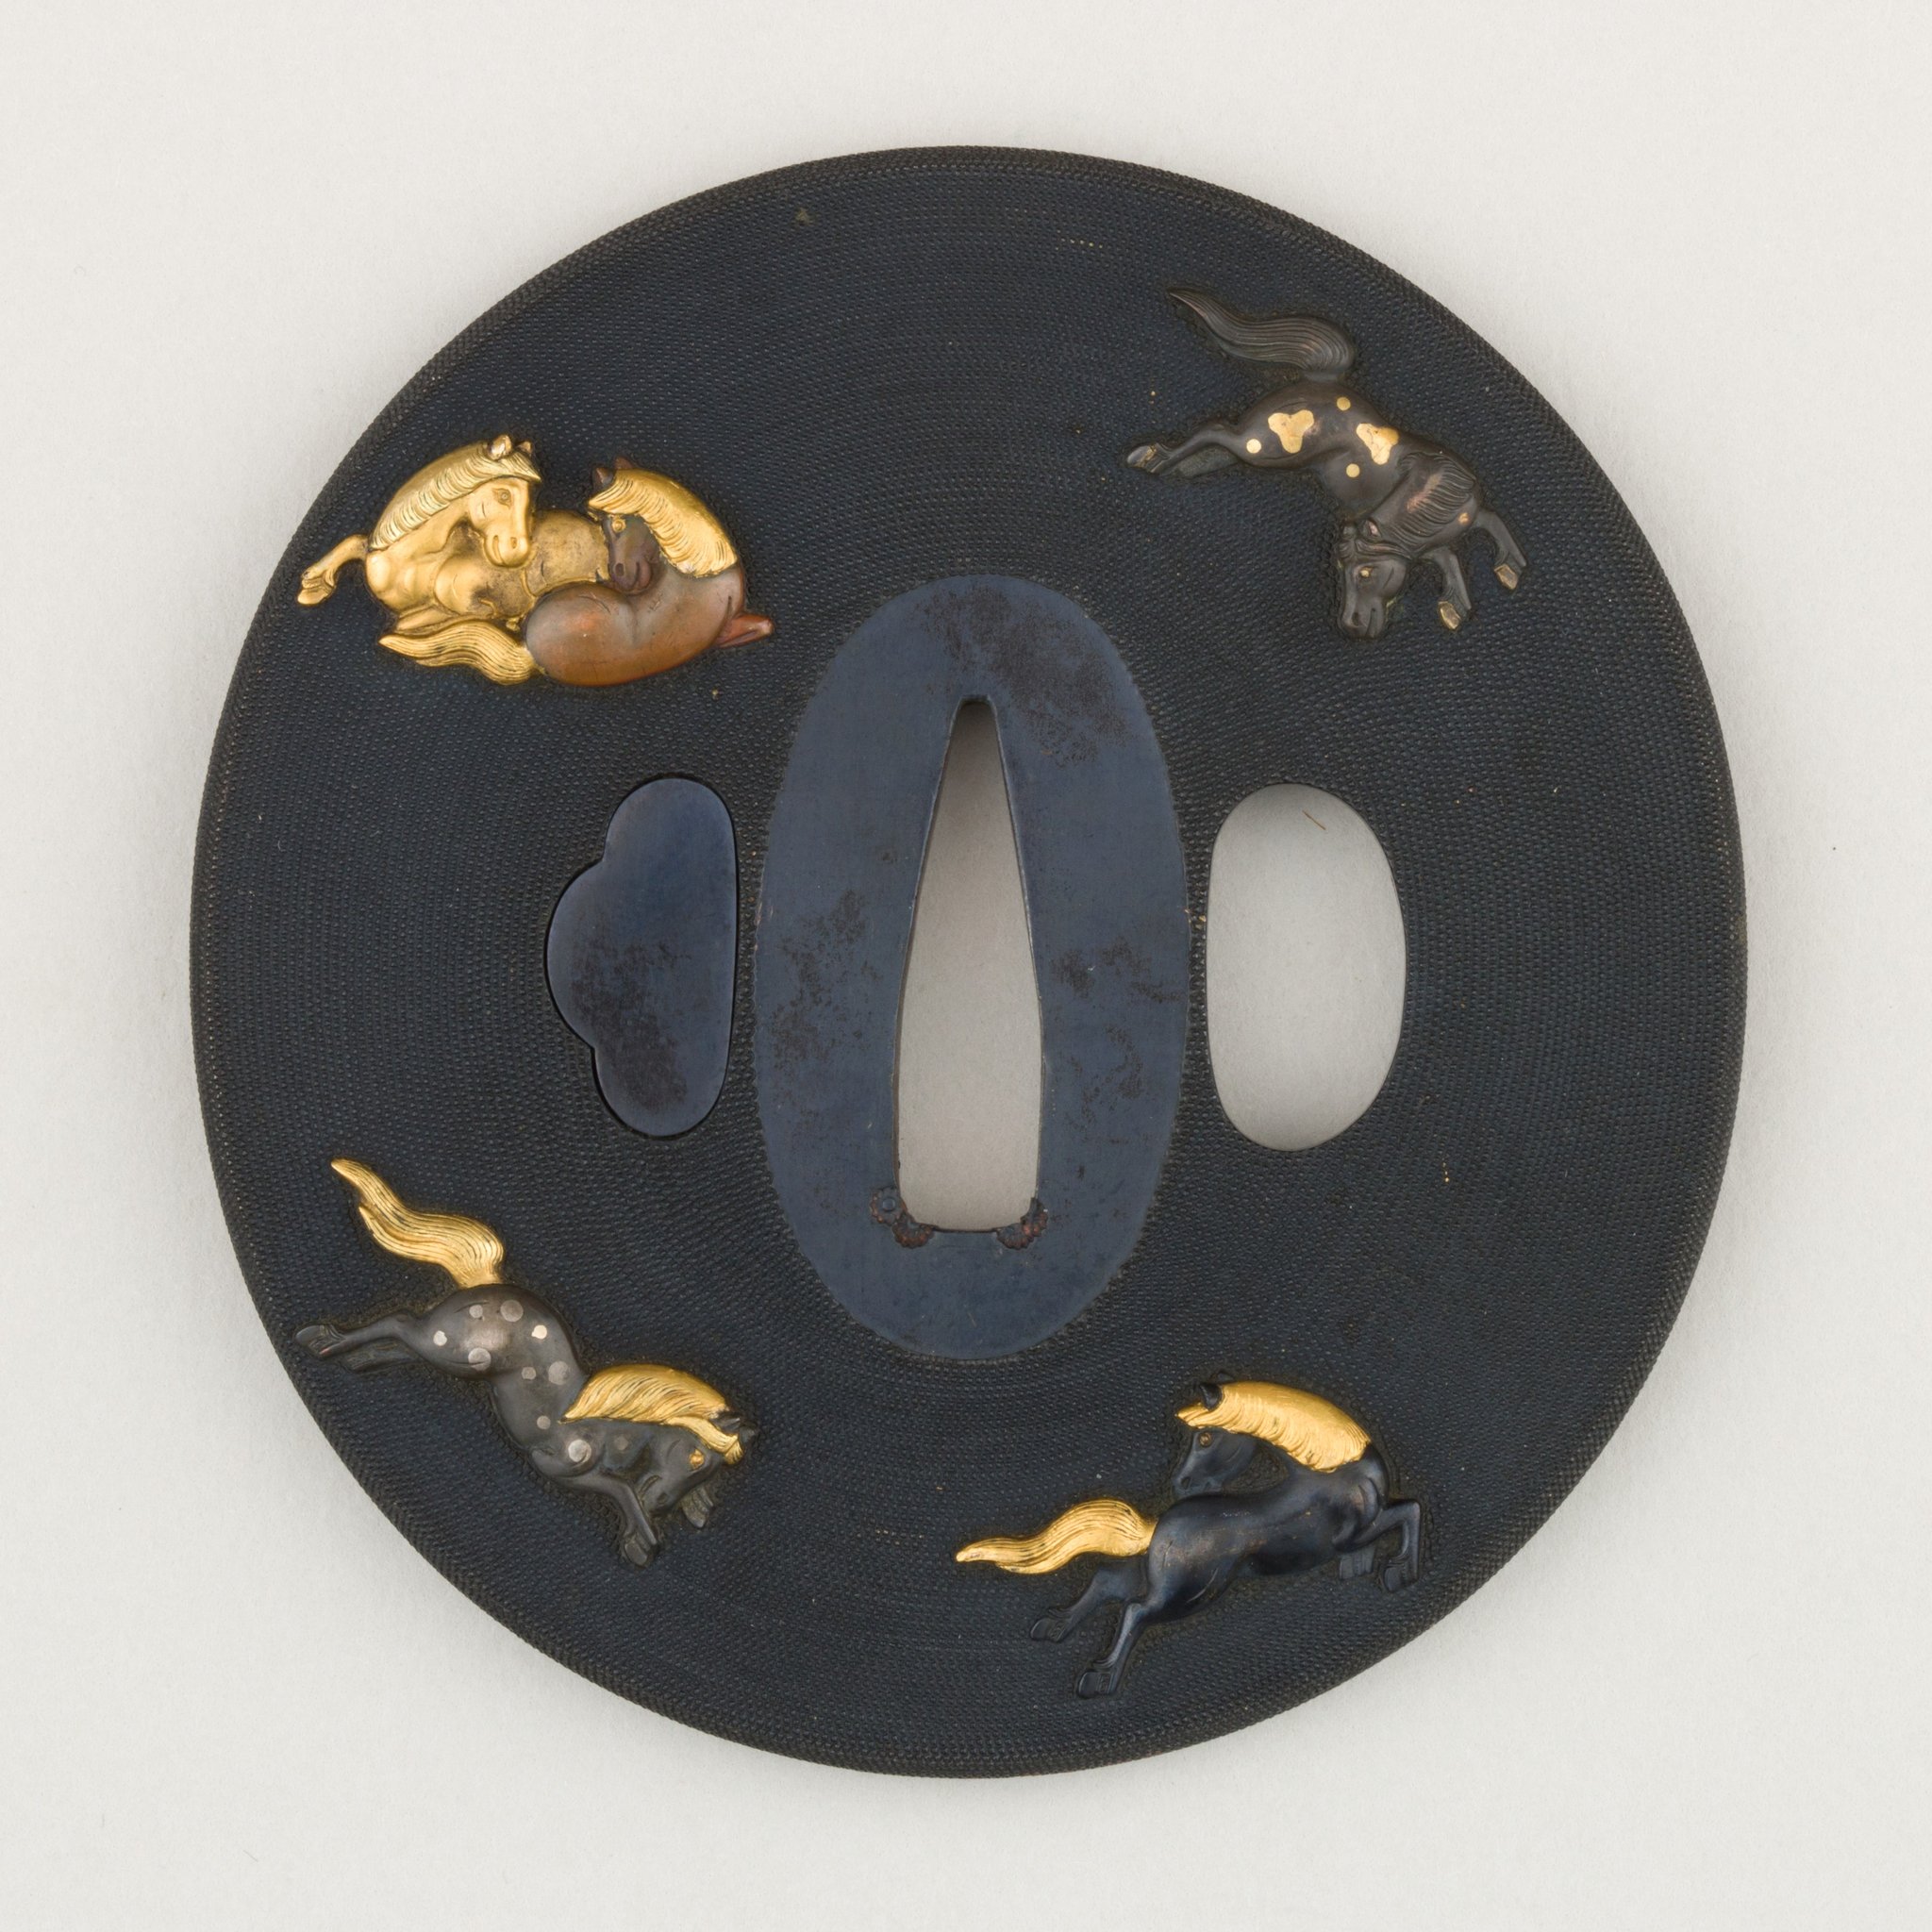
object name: sword guard tsuba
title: Sword Guard (Tsuba)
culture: japanese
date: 1801-1900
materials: bronze, copper, gold alloy, gold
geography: japan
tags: horses